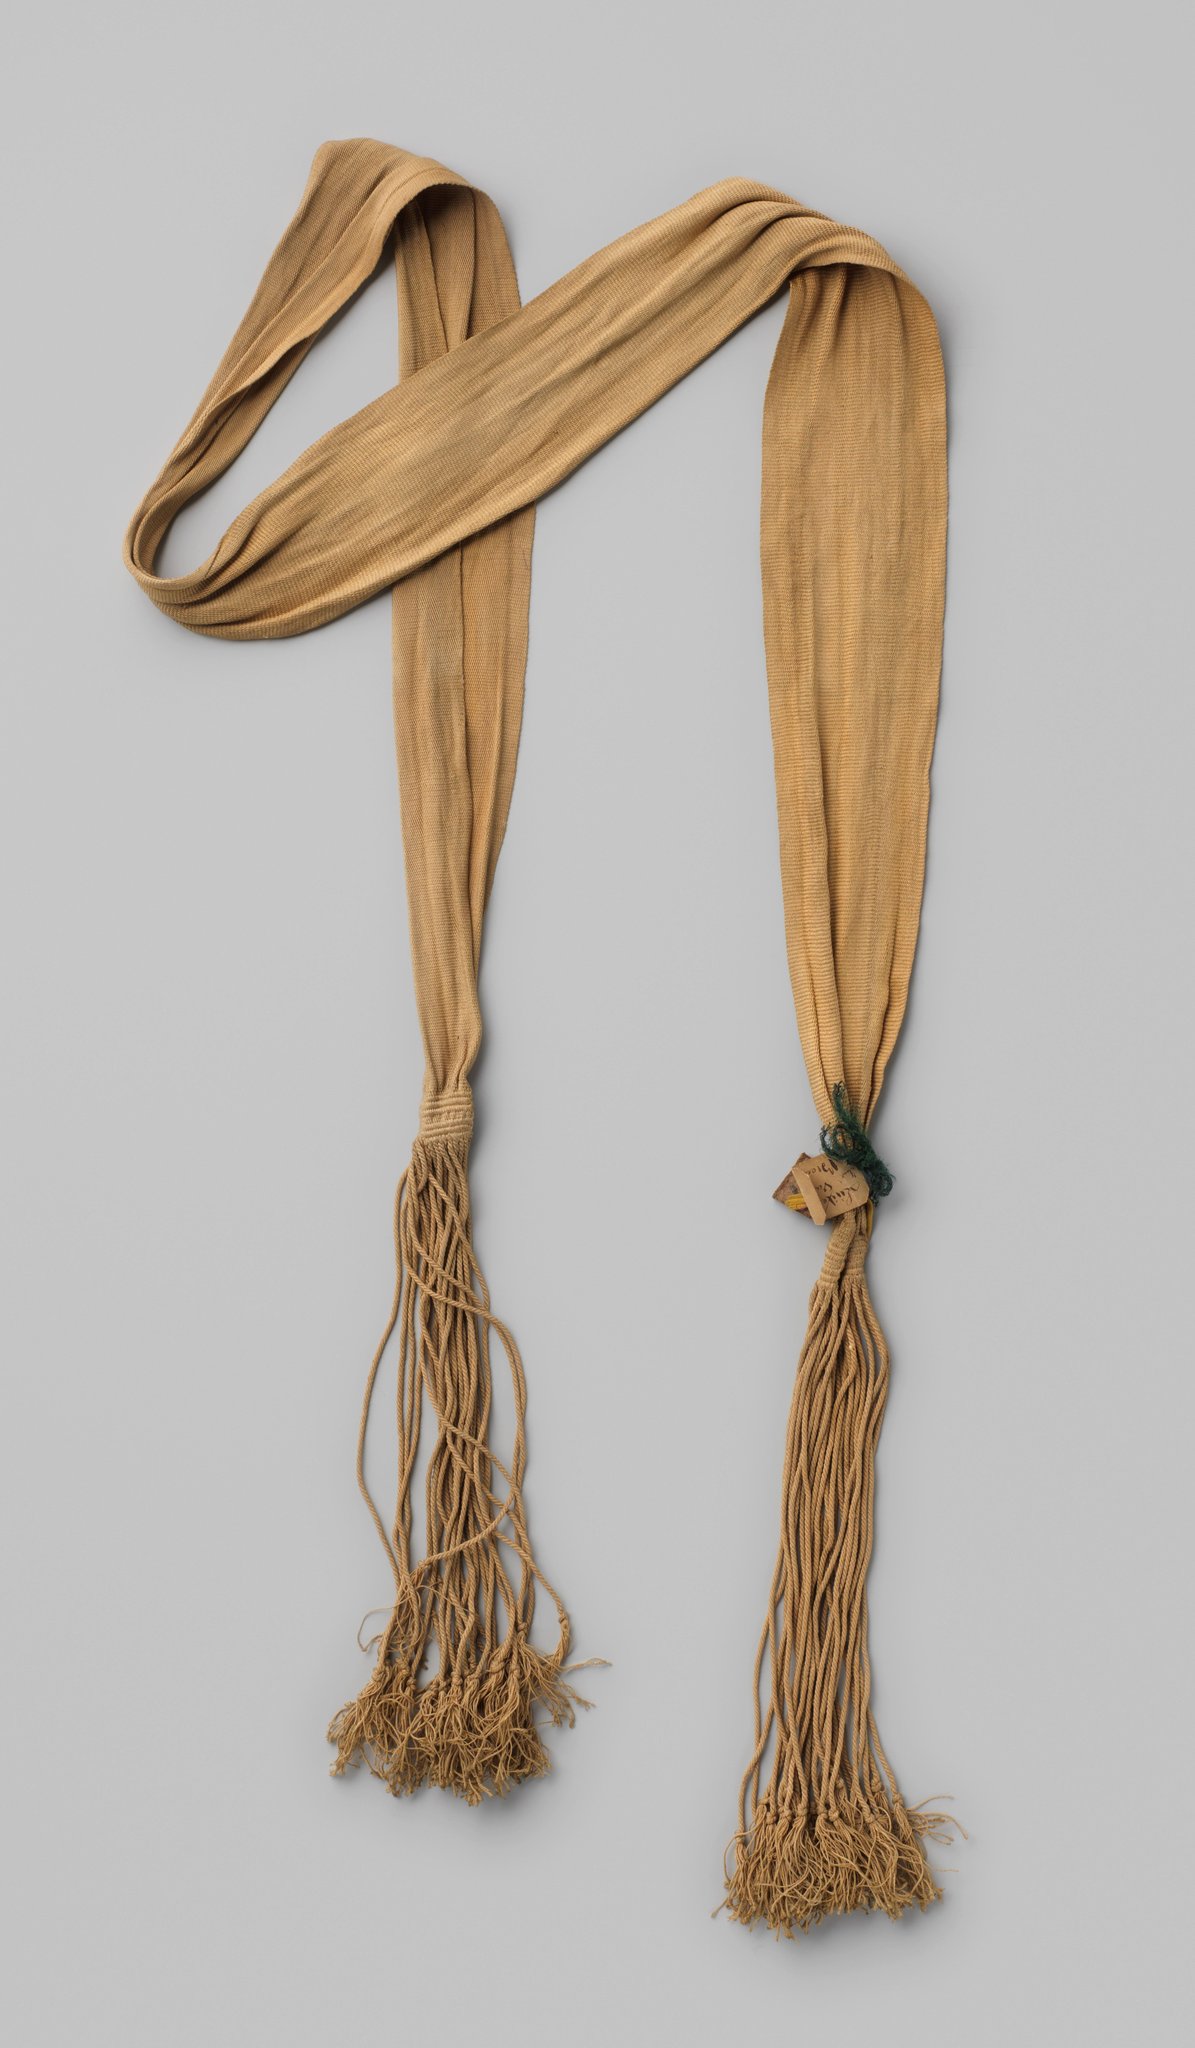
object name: sash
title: Sjerp gedragen door Jhr. G.P.C. van Breugel, in 1830/32 1e luitenant, 1e Bat., 2e Afd. N.H. Schutterij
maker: Anonymous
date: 1815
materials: silk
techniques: braiding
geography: netherlands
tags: netherlands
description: Sjerp van oranje koordzijde in techniek van Egyptisch vlechtwerk. Beide uiteinden eindigen in franjes met knopen aan de uiteinden. Aan een zijde hangt aan een oranje-blauw lint een leren label met nr. 57. Hierbij de tekst: luitenant jokh. van Breugel. Sjerp van oranje koordzijde (Ned. leger) (M.1815).